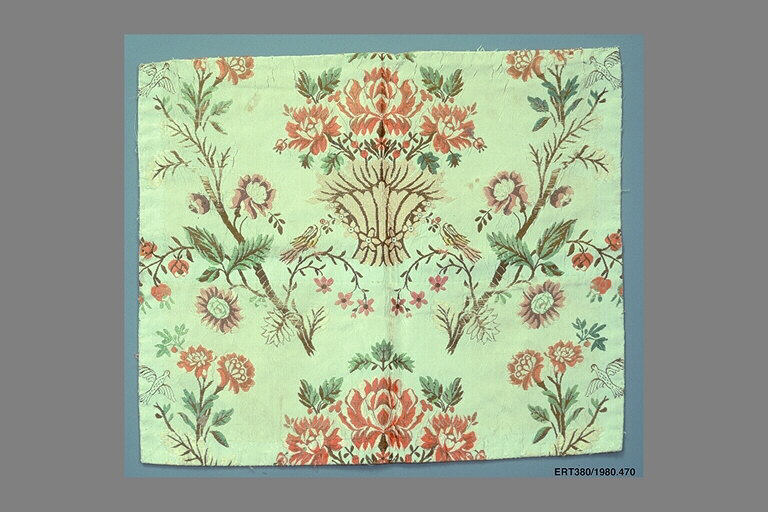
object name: piece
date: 1701-1800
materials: silk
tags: flowers,leaves